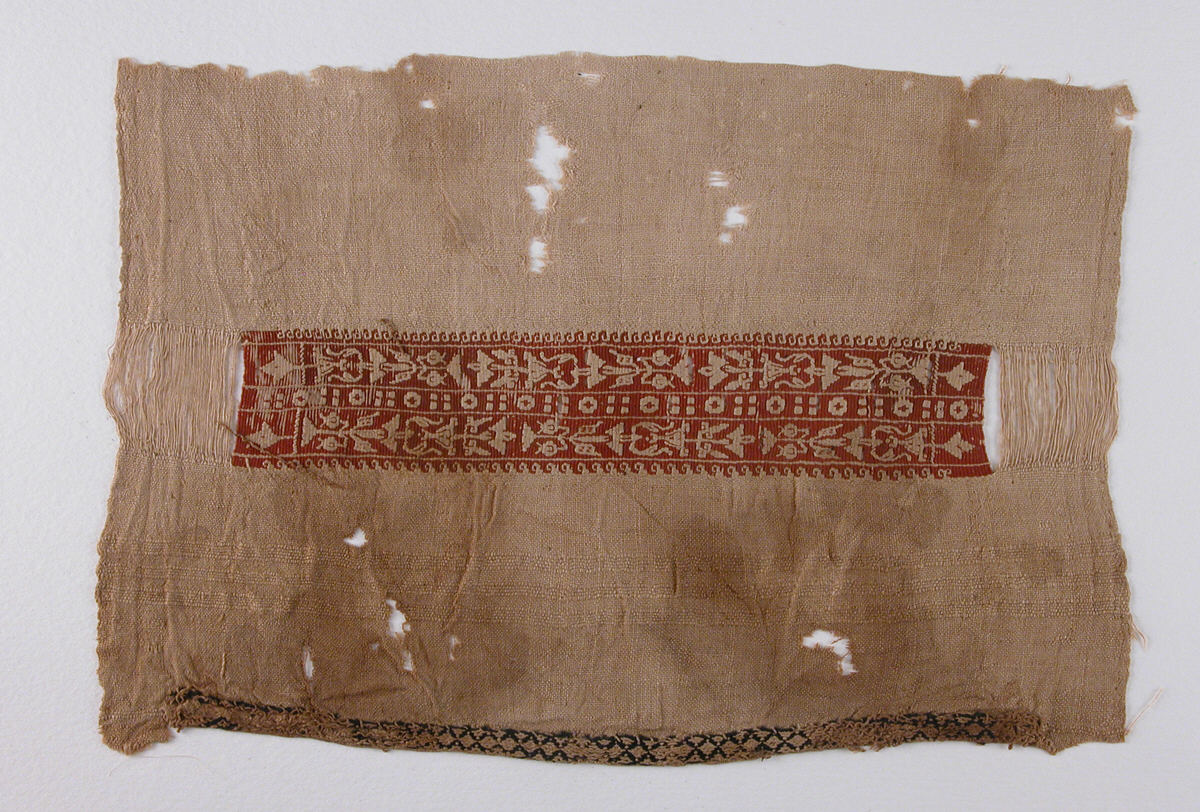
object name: textile fragment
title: Fragment of a Sleeve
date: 301-400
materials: linen, wool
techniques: weave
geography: egypt